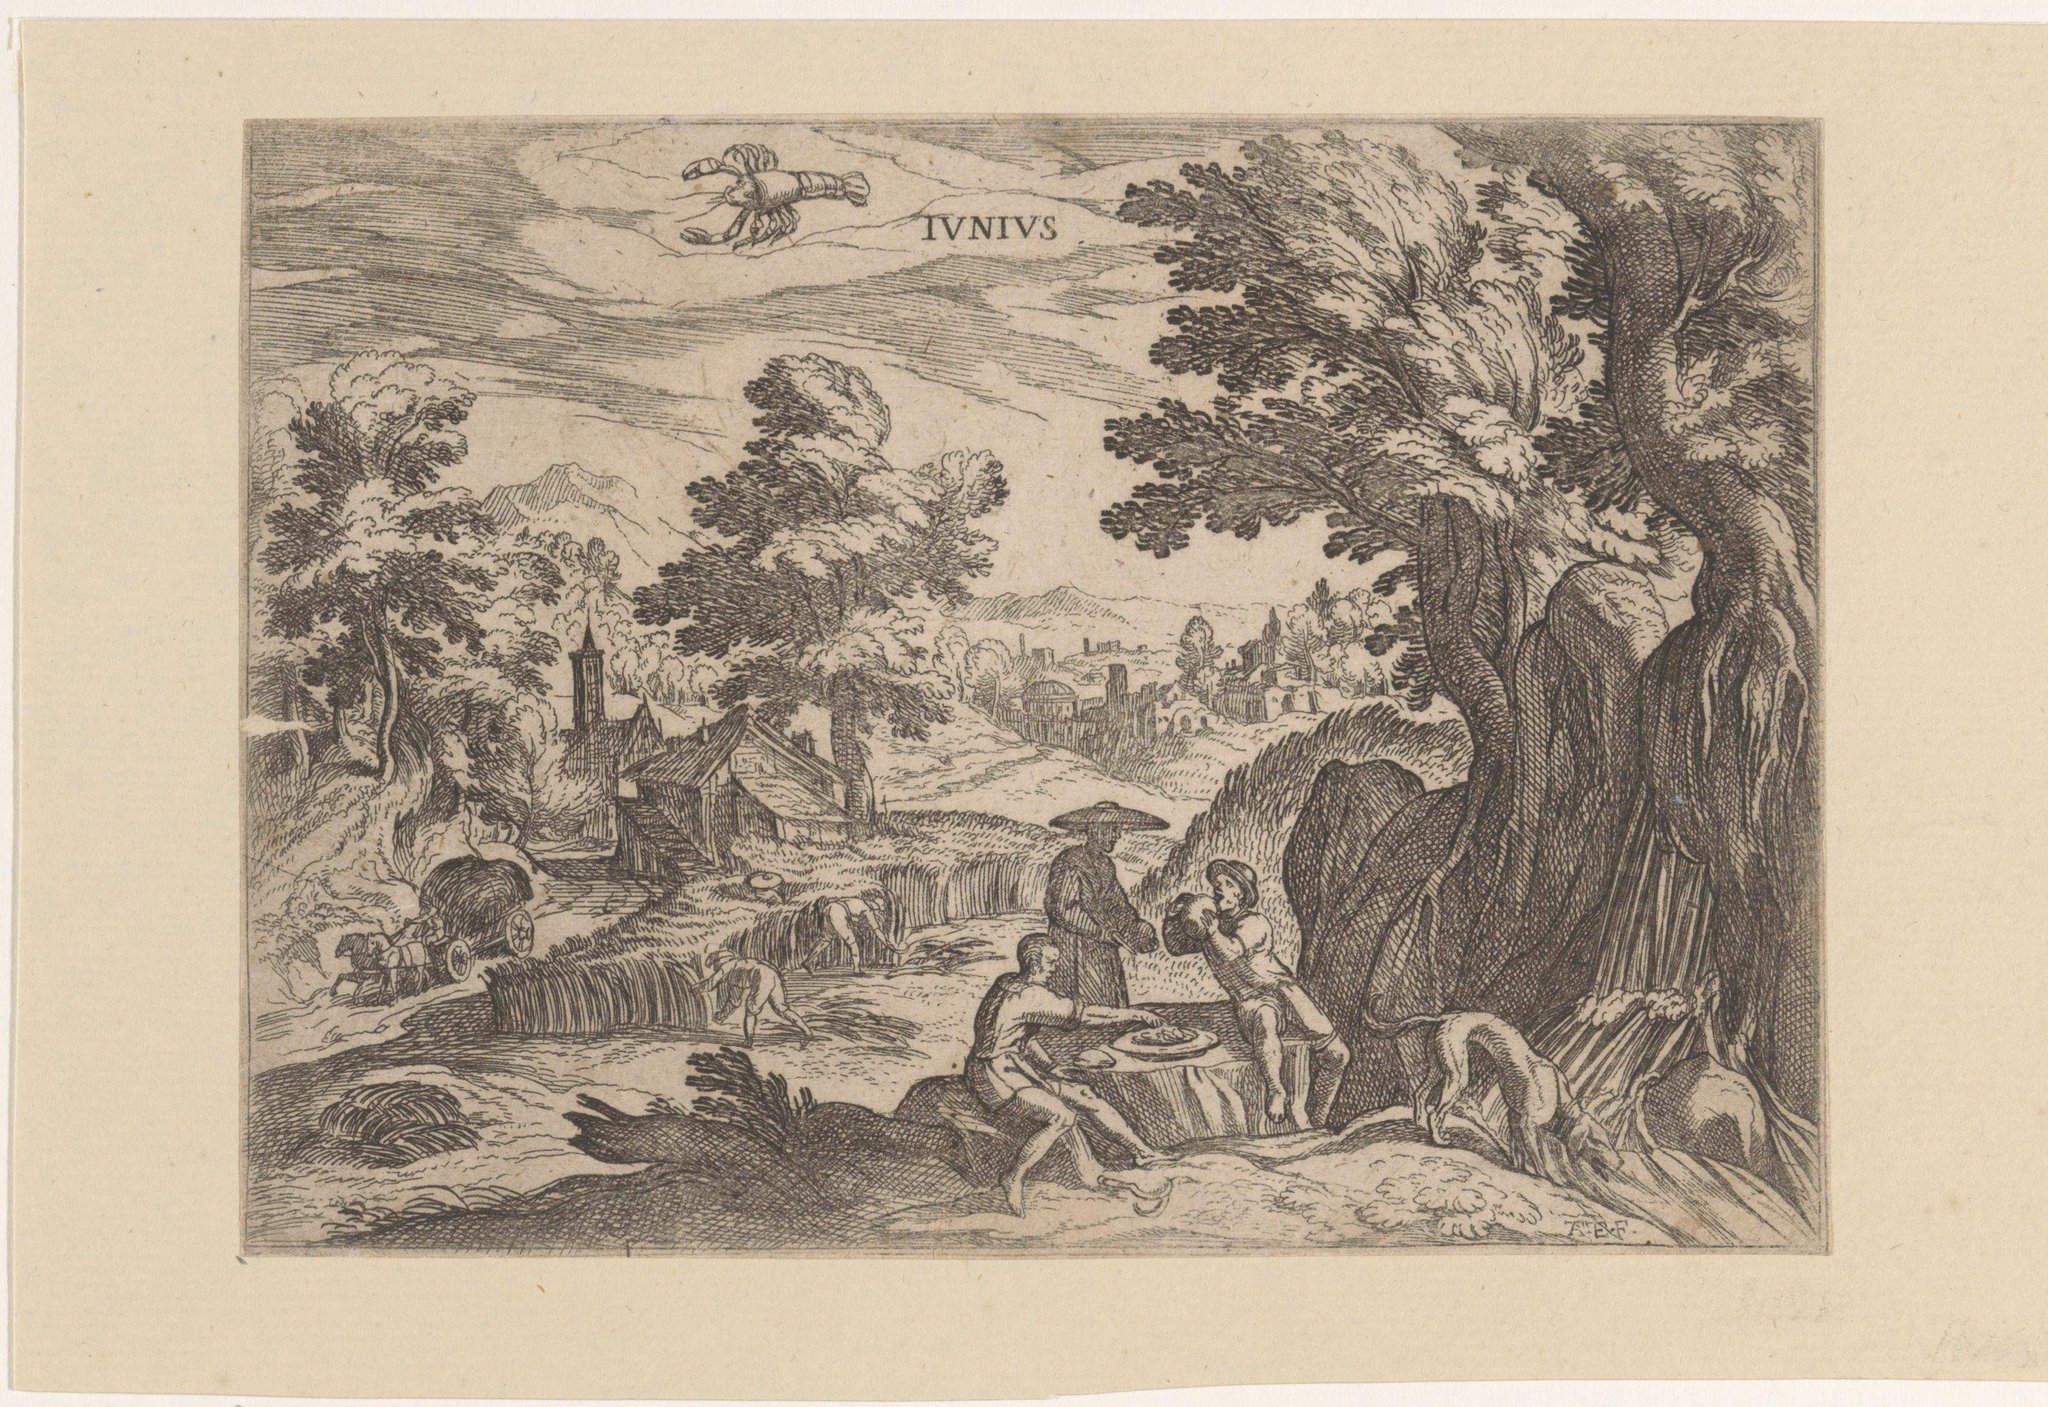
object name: print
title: Juni: maaien (kreeft)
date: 1575-1613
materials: paper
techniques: etching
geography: italy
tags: cancer (zodiacal sign of june), landscape symbolizing june, farmers, reaping, picking, mowing ~ harvest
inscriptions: collector's mark: Lugt 240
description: Landschap dat de maand juni verbeeldt. Landschap met rustende boeren en boeren die het koren maaien. Midden boven het symbool voor het sterrenbeeld kreeft.